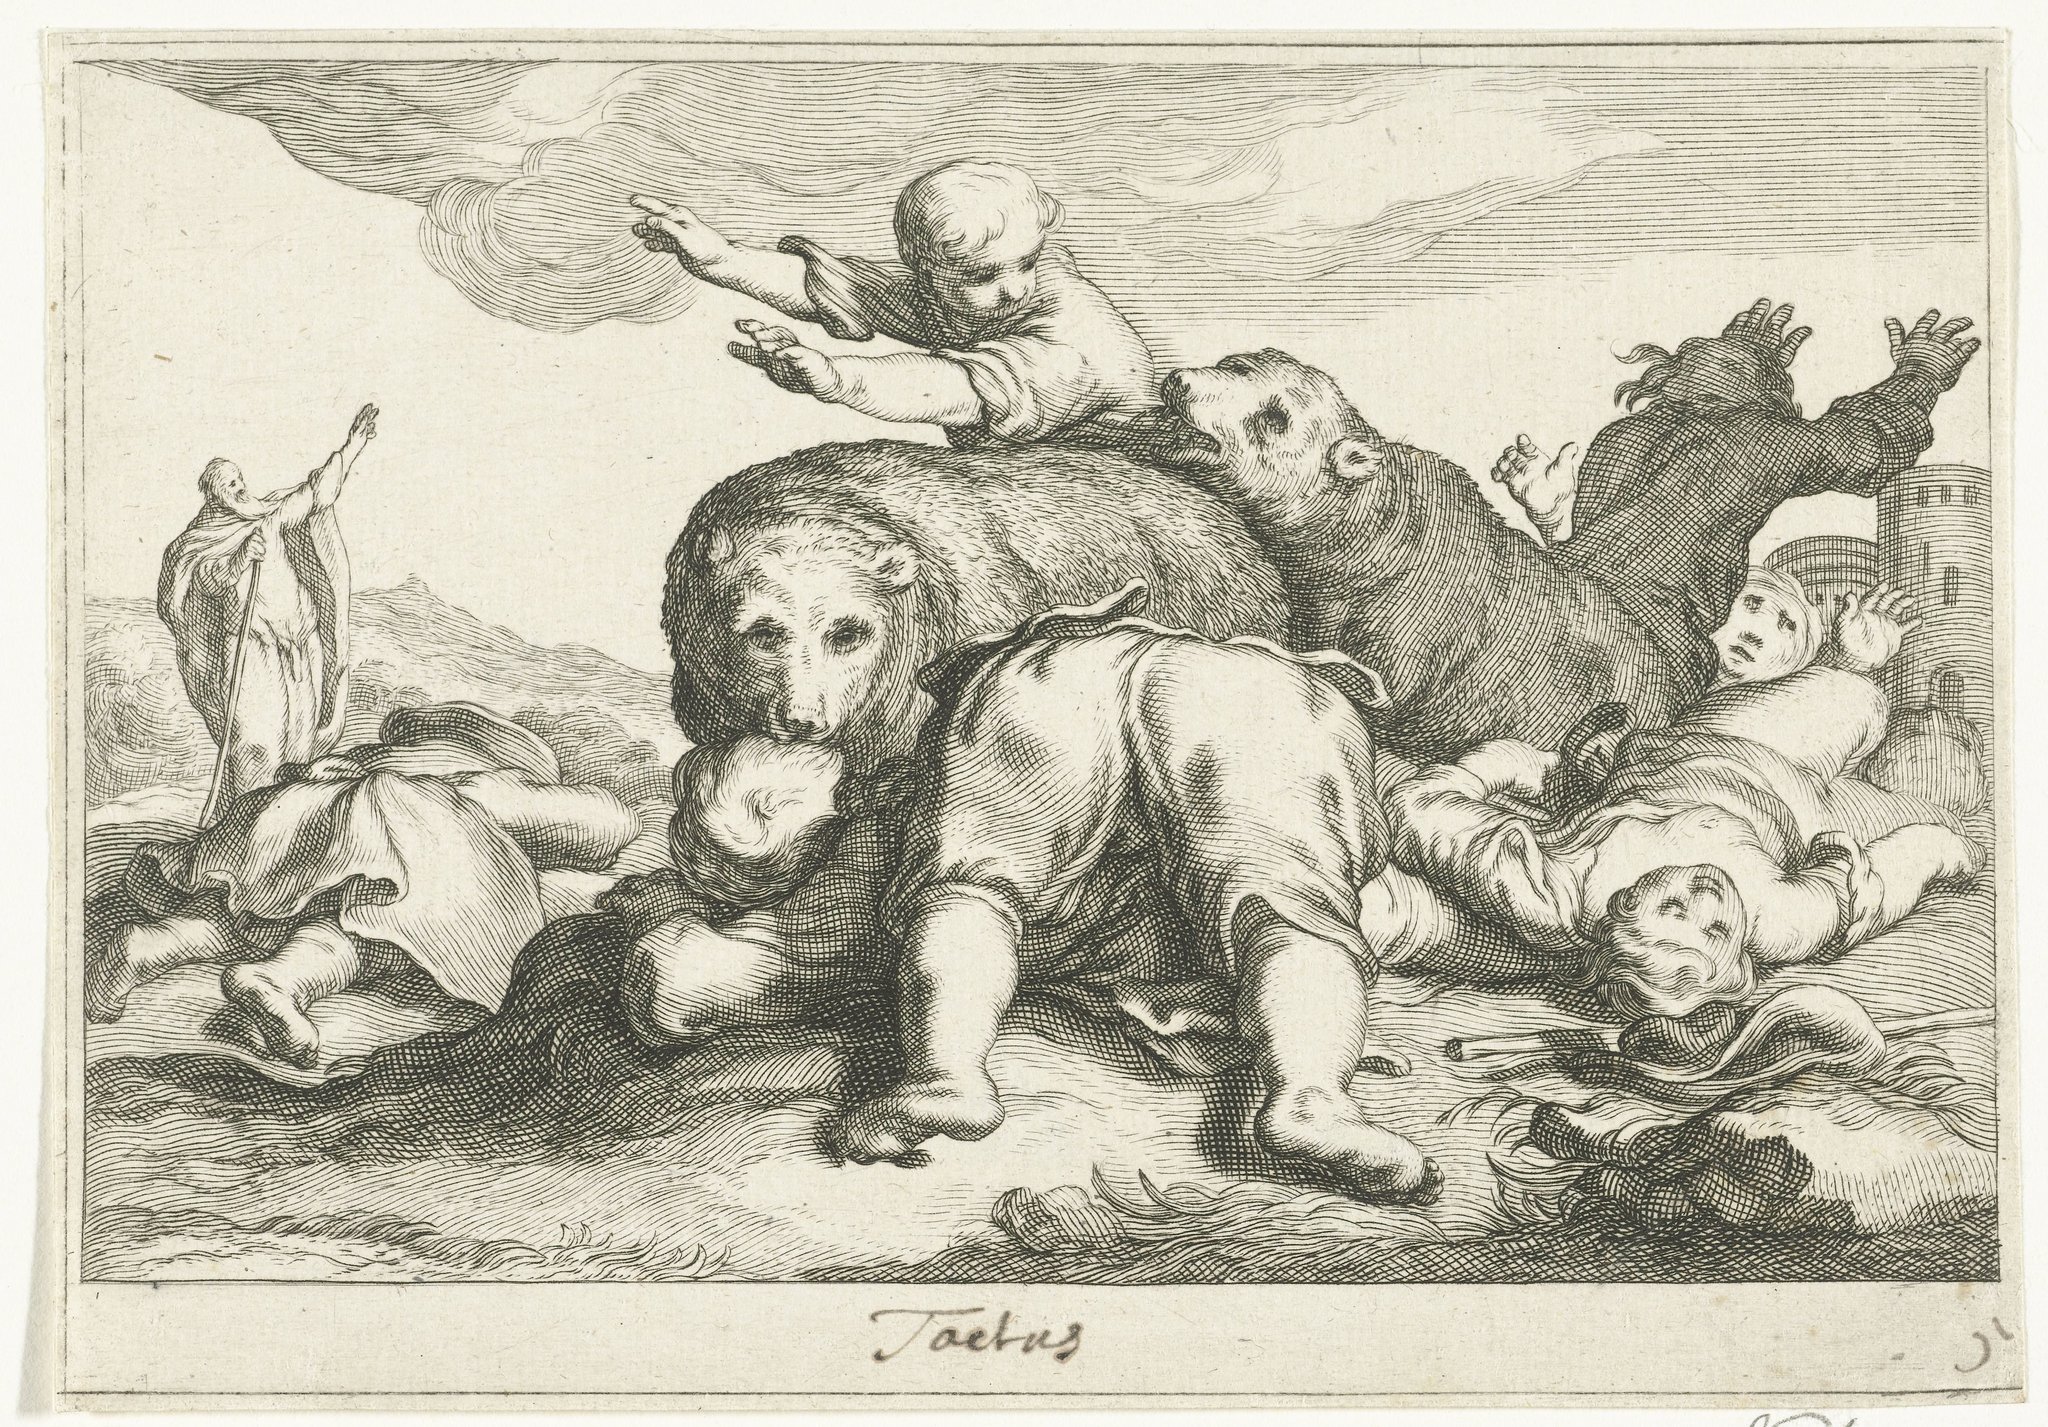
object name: print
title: Tast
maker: frederick bloemaert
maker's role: print maker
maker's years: 1614-1669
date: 1632-1670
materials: paper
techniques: engraving, etching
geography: utrecht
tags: two bears come out of the woods and tear the children who were mocking elisha to pieces, feeling (one of the five senses)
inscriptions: collector's mark: Lugt 240, number: ‘5’, inscription: ‘Tactus’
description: De profeet Elisa, links op de achtergrond, vervloekt de kinderen die hem bespotten. Als straf worden deze door beren verslonden. Voorstelling van de Tast, uit een serie met vijf prenten die de zintuigen afbeelden.